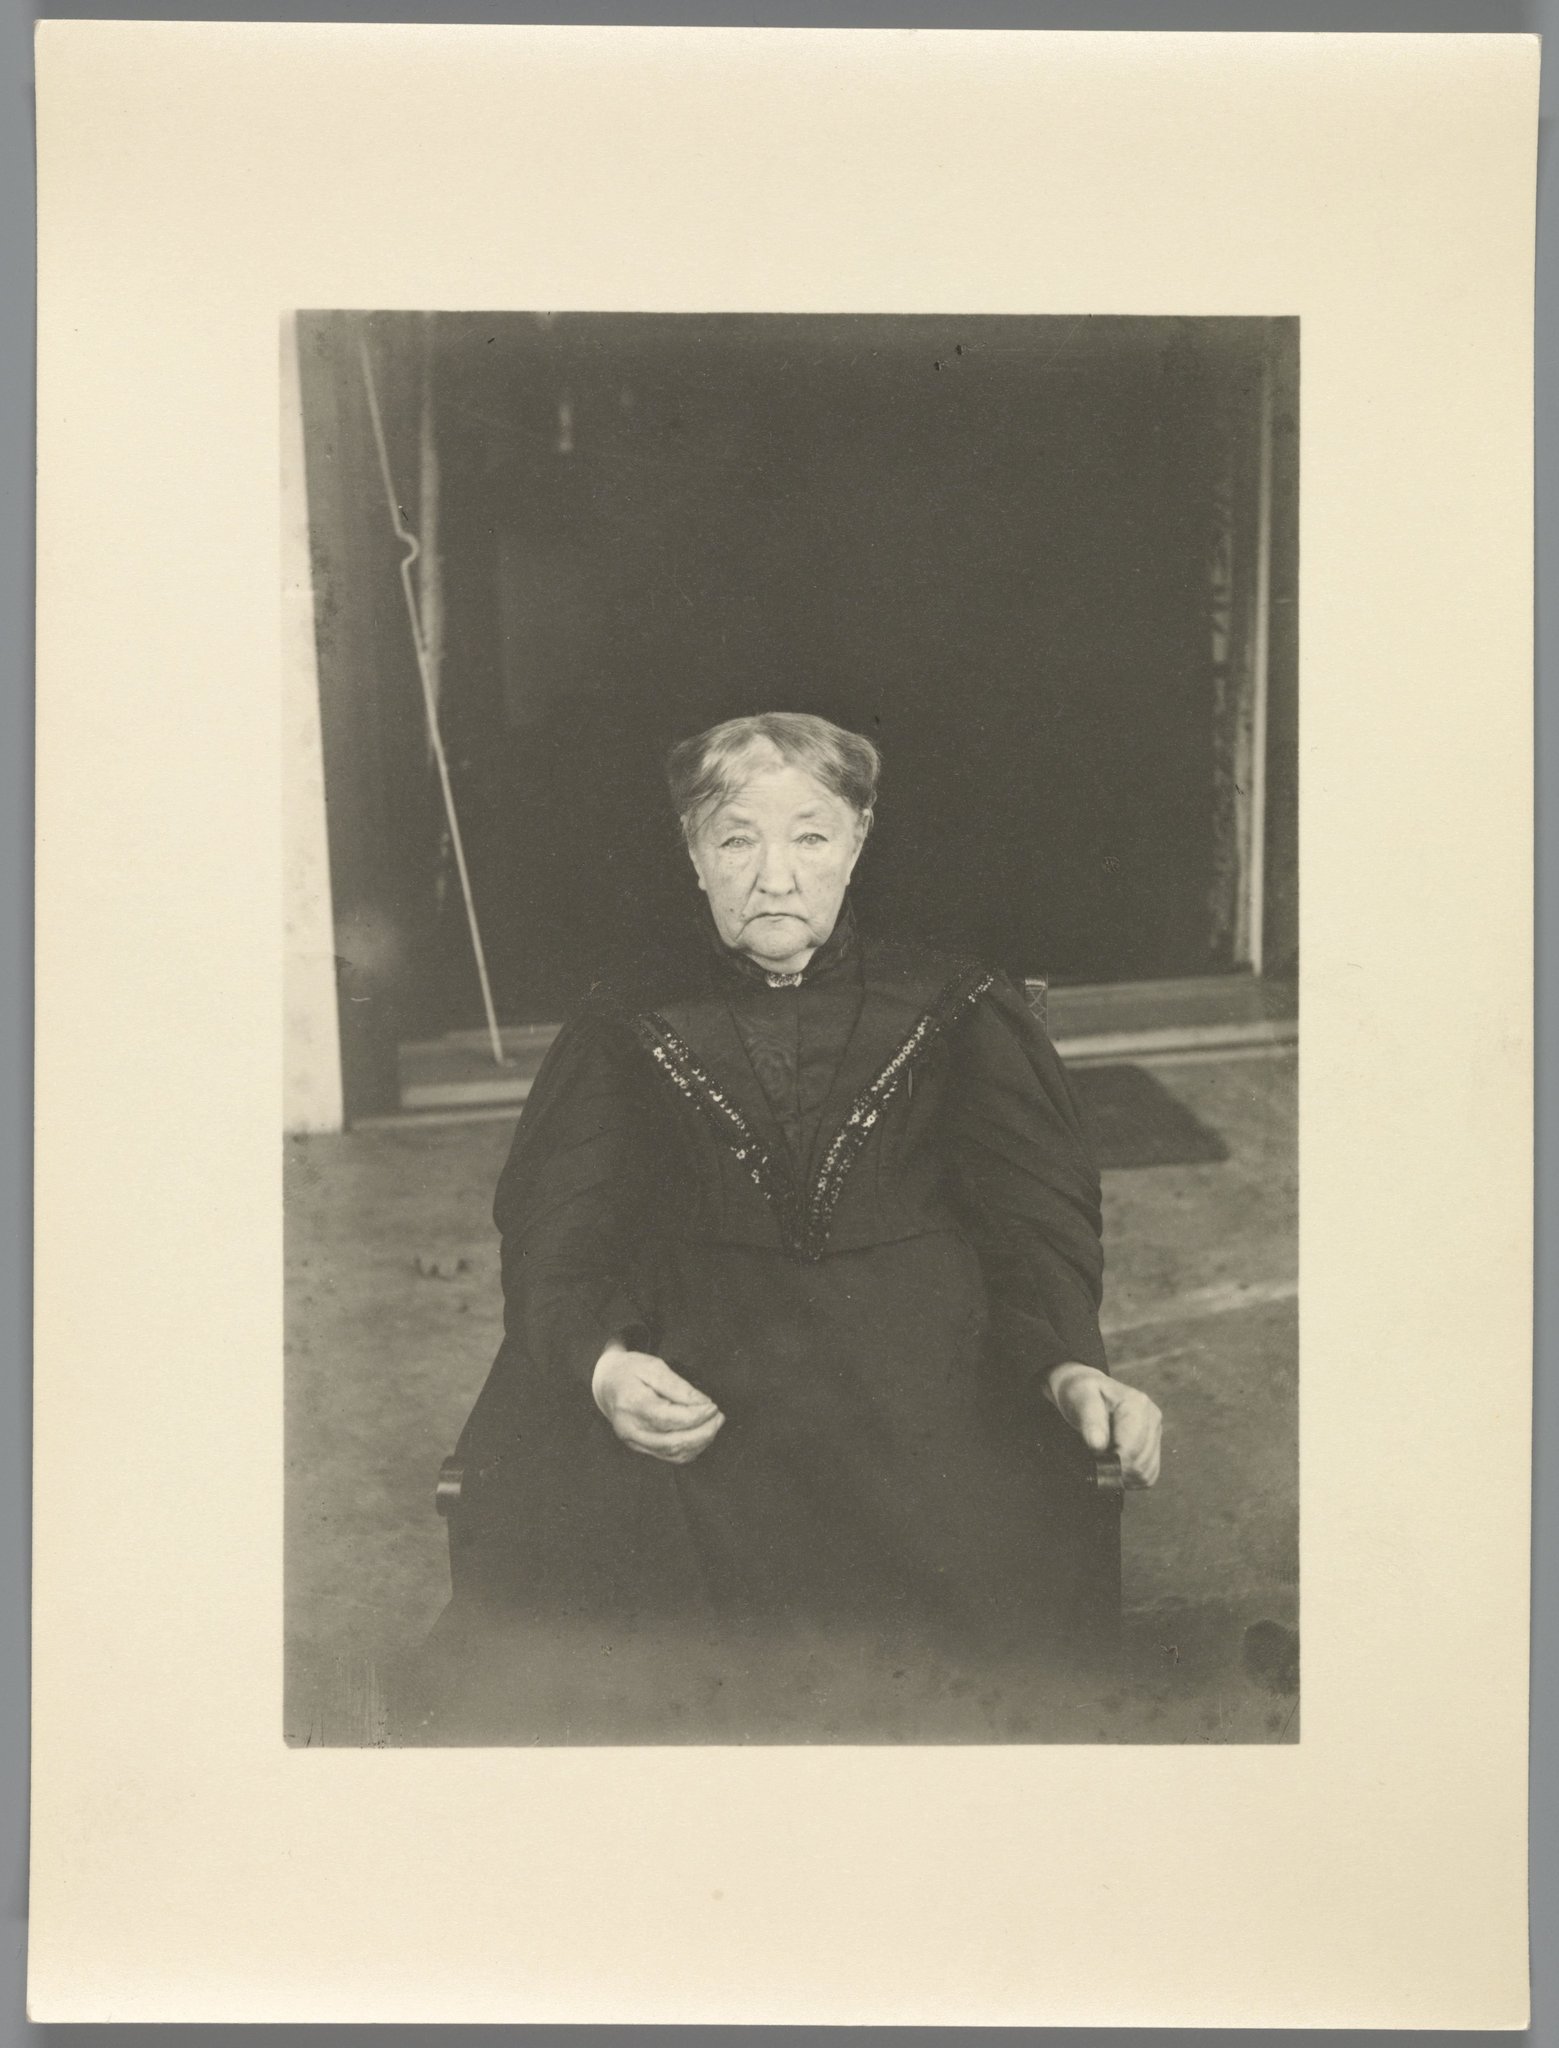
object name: photograph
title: Reproductie naar een foto van Willem Witsen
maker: Anonymous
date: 1860-1915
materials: paper, photographic support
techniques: gelatin silver print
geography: netherlands